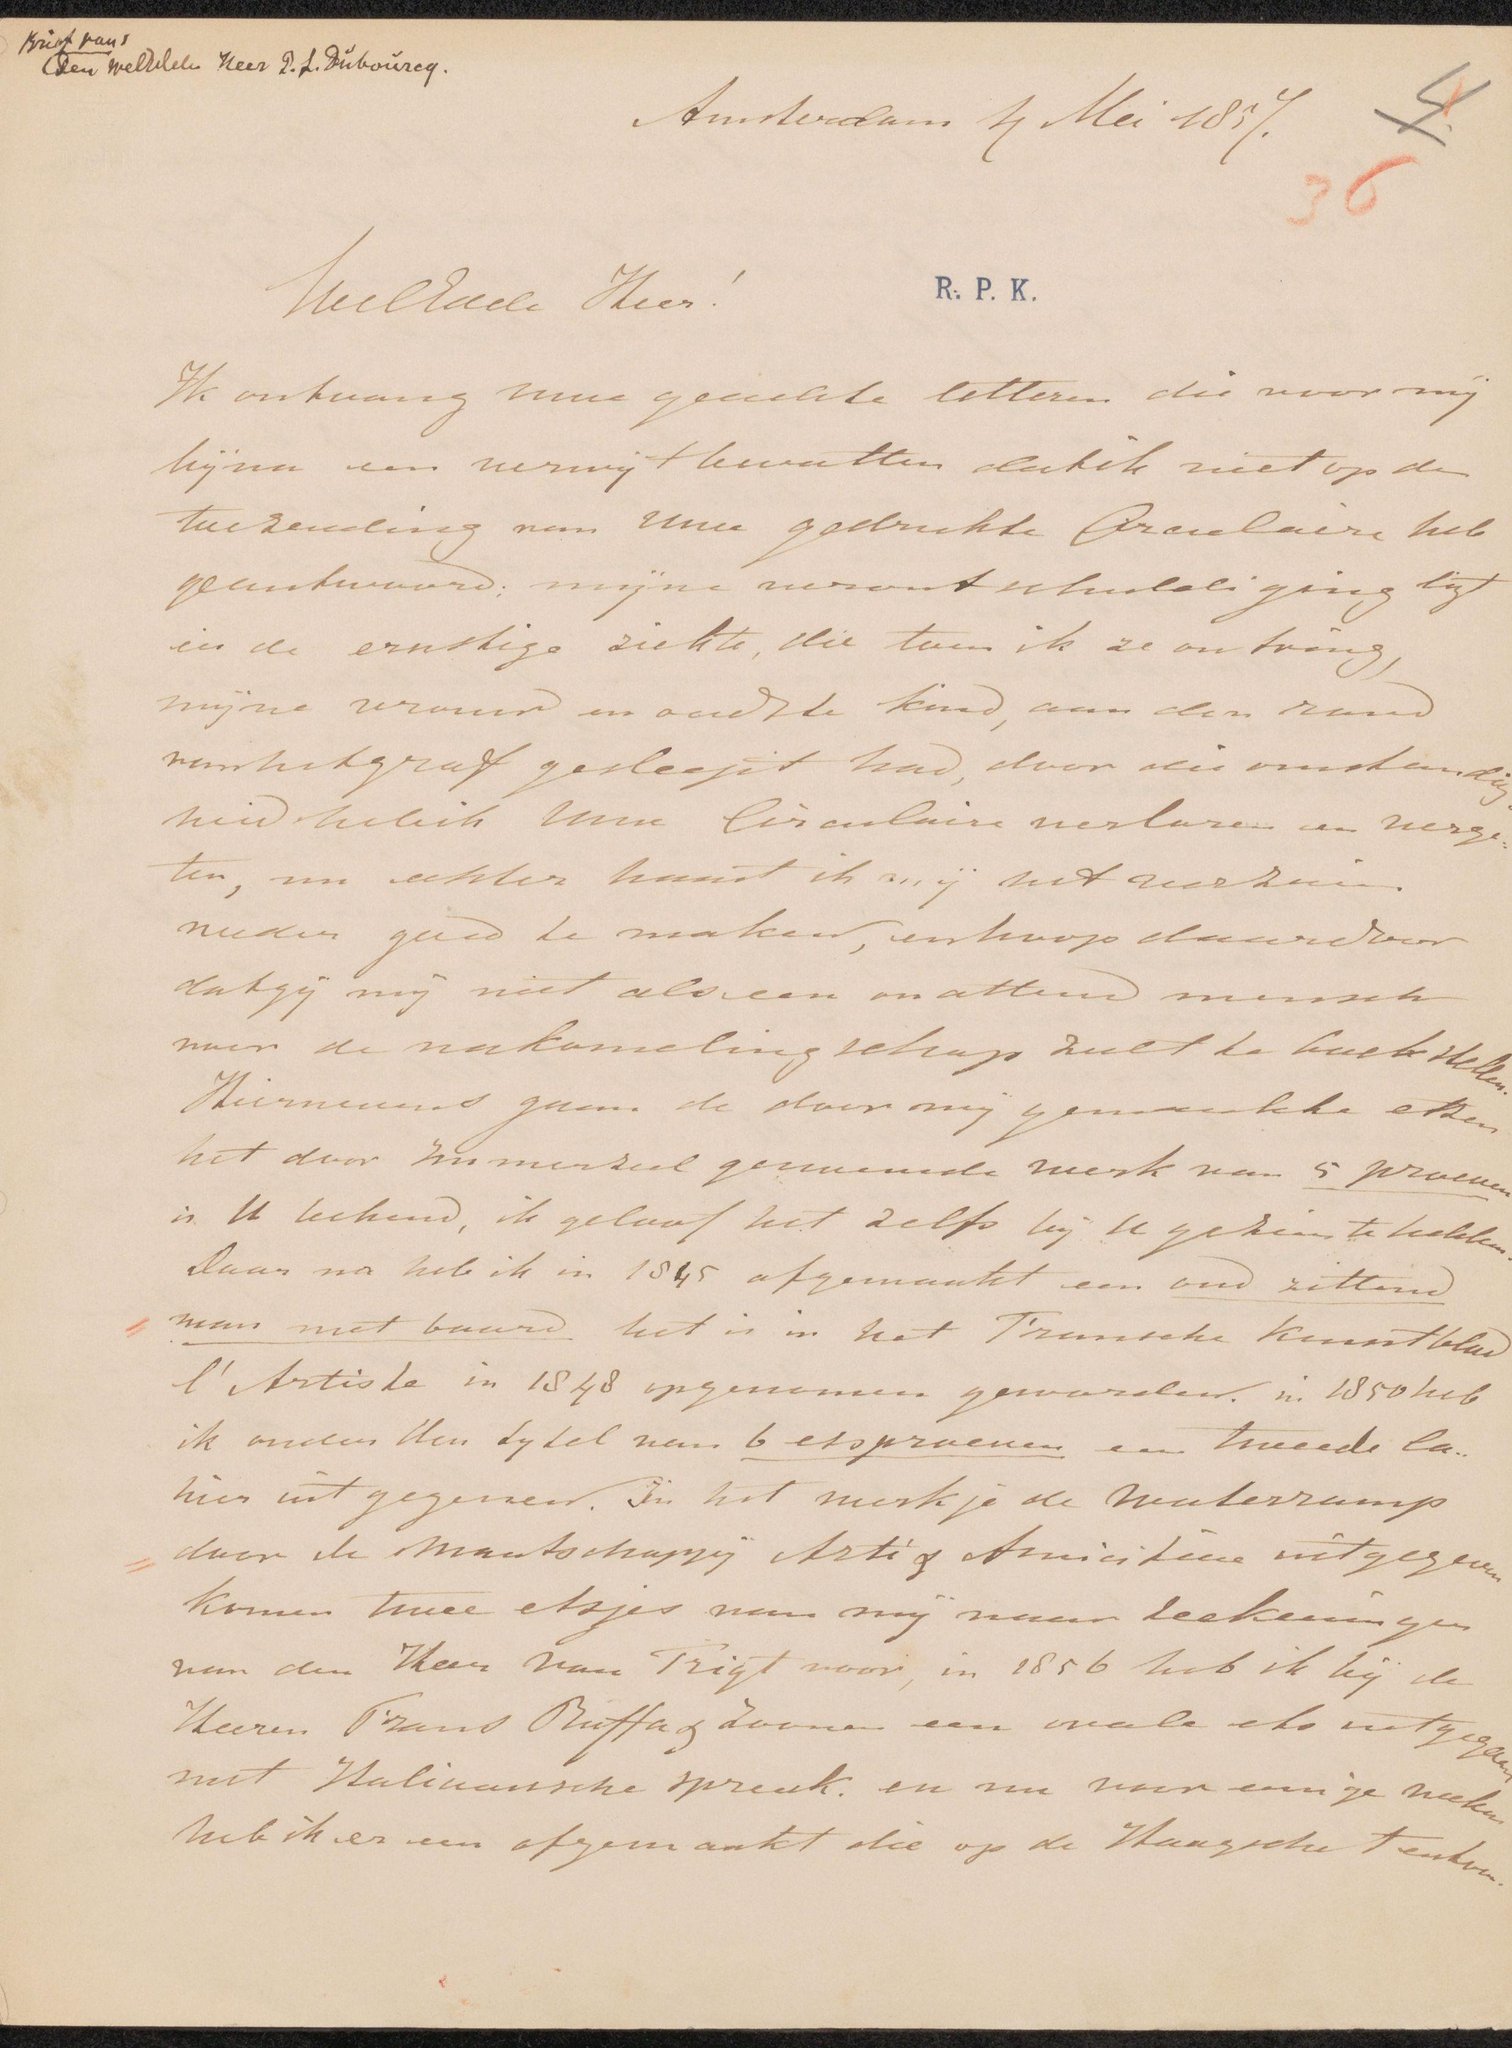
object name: letter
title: Brief aan Christiaan Kramm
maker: pierre louis dubourcq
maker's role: draughtsman, painter, print maker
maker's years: 1815-1873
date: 1857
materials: ink, paper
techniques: pen, writing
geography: amsterdam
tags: publisher, johannes immerzeel, painter, print maker, draughtsman, hendrik albert van trigt, utrecht, christiaan kramm, the graphic arts, family life, travelling; tourism, painting (including book-illumination, miniature-painting), diseases, printed matter, italy, germany, france, england, belgium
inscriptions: collector's mark: Lugt 2233